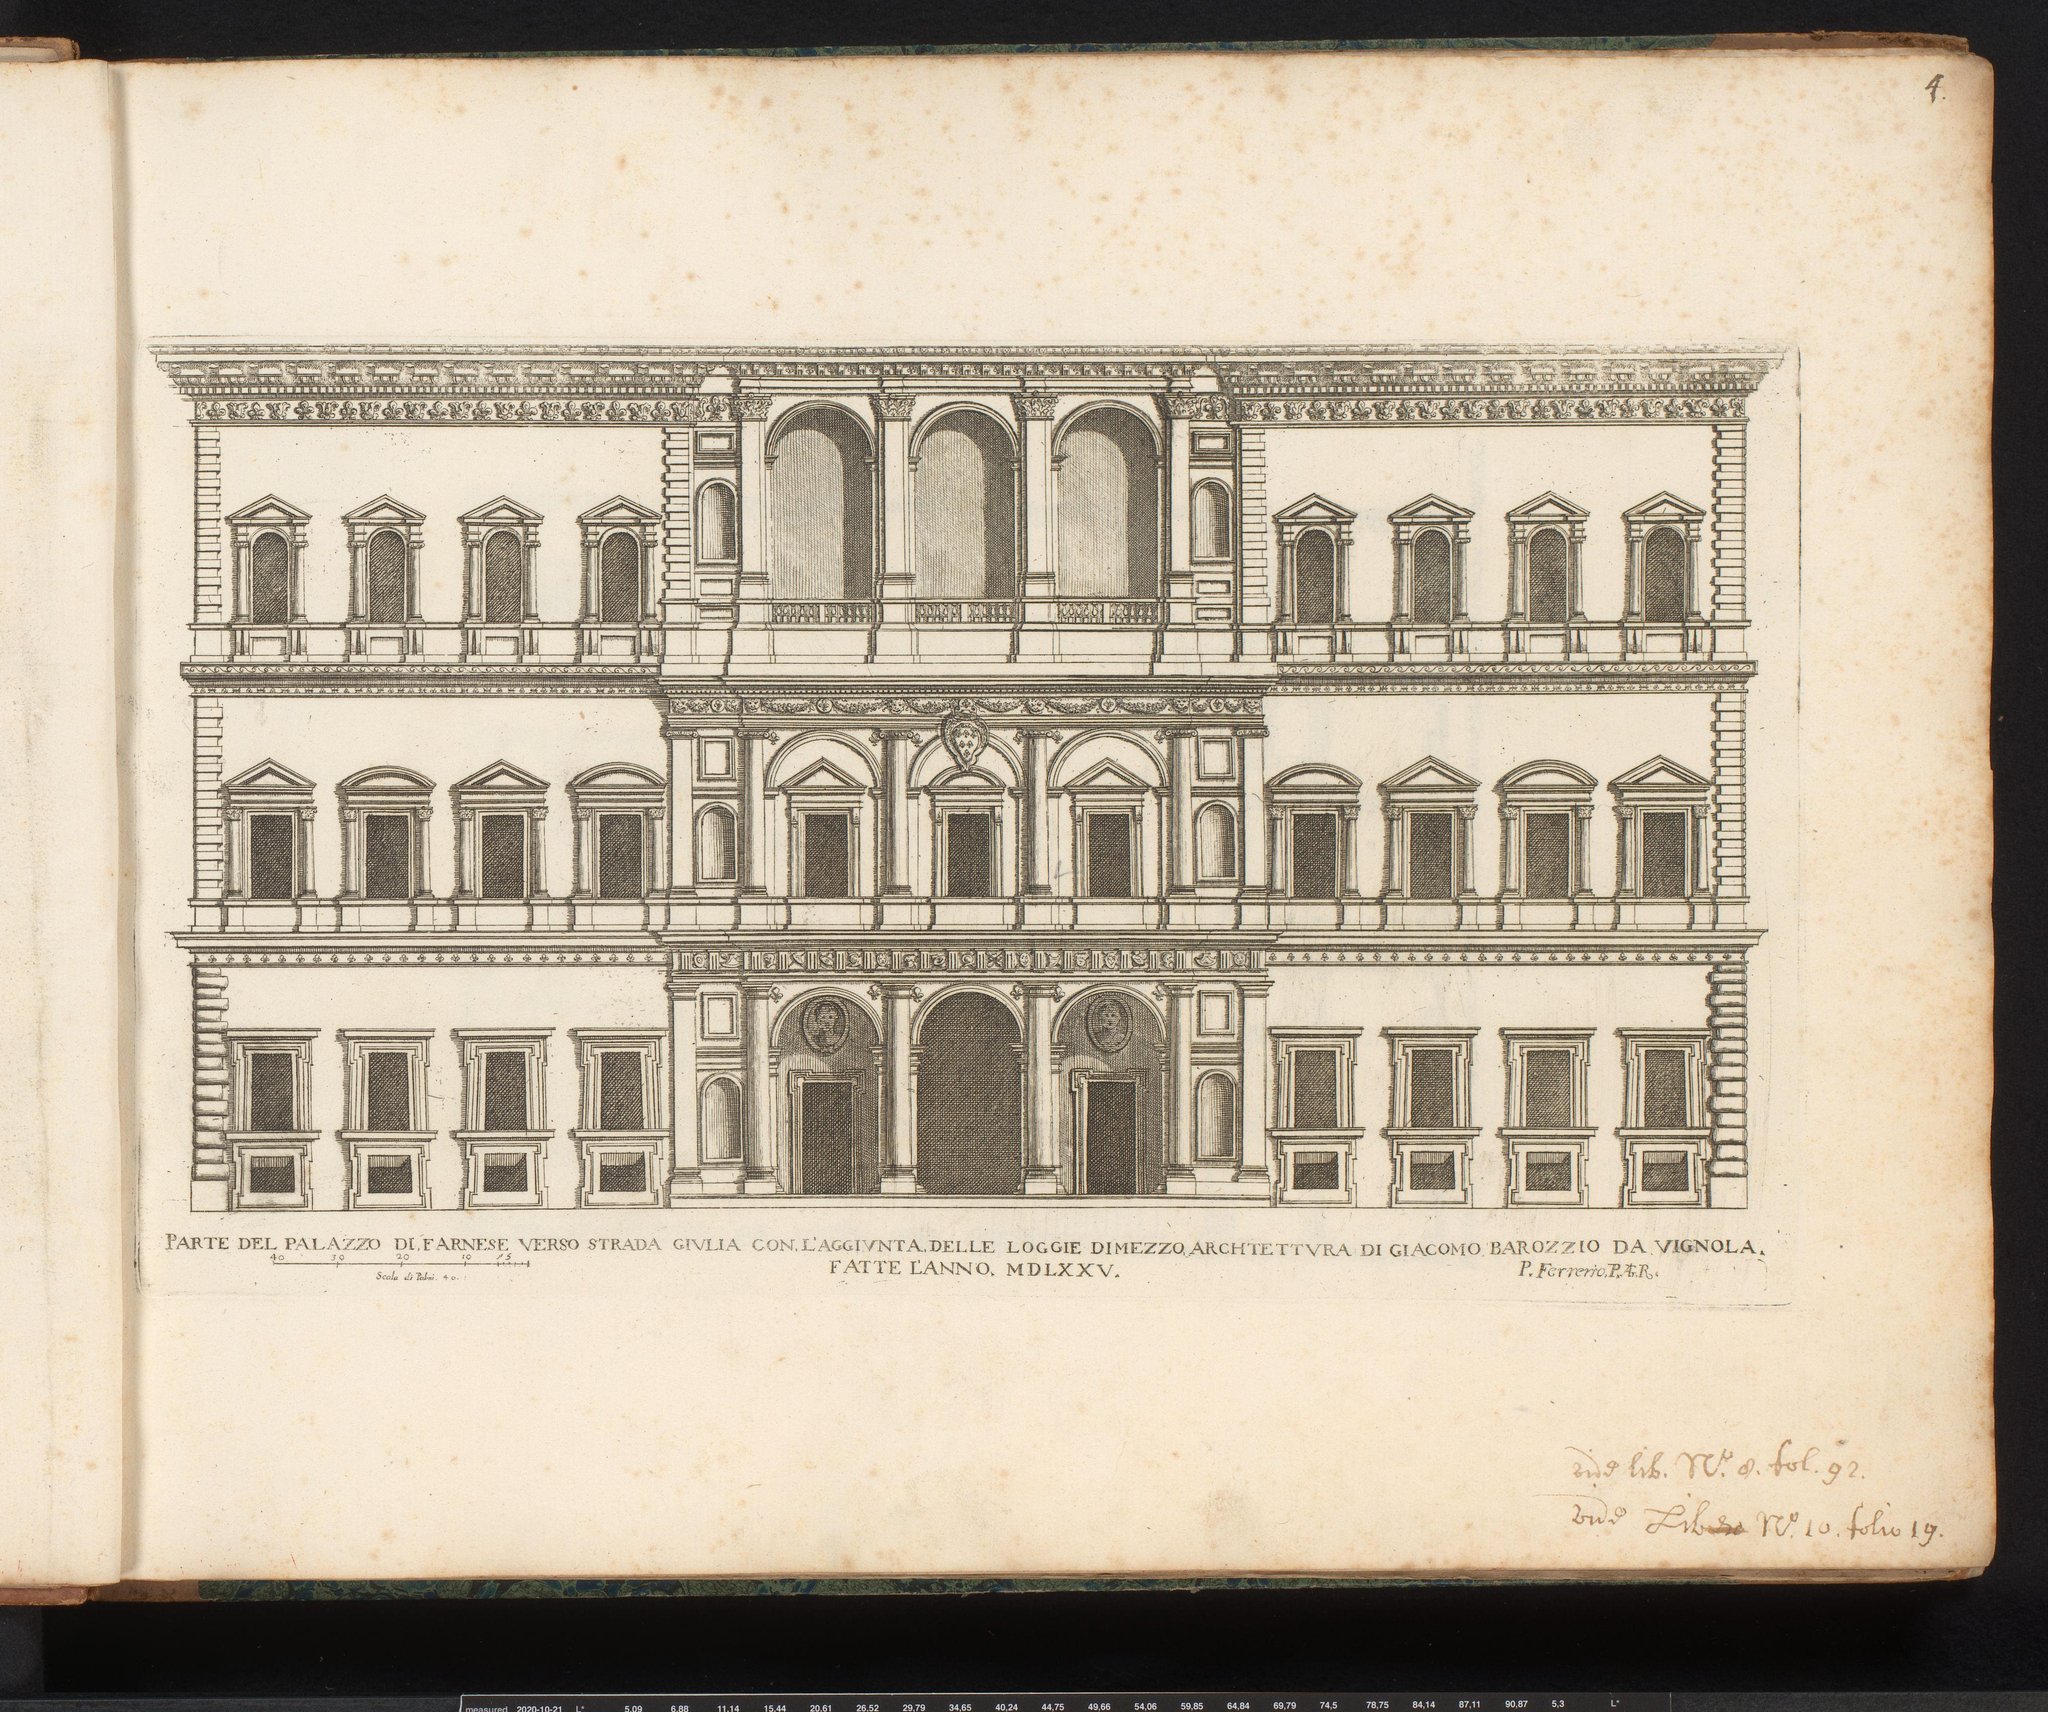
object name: print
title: Palazzi di Roma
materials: paper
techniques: etching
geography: italy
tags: palace, façade (of house or building)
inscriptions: inscription: ‘Ende lib. No. 8. fol. 92./ Ende lib. No. 10. folio 19.’, number: ‘4’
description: Deze prent maakt deel uit van de reeks getiteld: Palazzi di Roma. Deze reeks bestaat uit twee boeken. Boek één getiteld: Palazzi di Roma dei più celebri architetti..., bestaat uit 44 prenten die worden toegeschreven aan Giovanni Battista Falda (naam staat enkel op prent 27) en uitgegeven door Giovanni Giacomo de'Rossi. Deze 44 prenten zijn bekend in twee staten (met en zonder nummer). Boek twee getiteld: Nuovi disegni dell'architetture... libro secondo, bevat 66 prenten door Giovanni Battista Falda en Simone Felice. Deze 66 prenten zijn bekend in twee staten (met en zonder nummer).